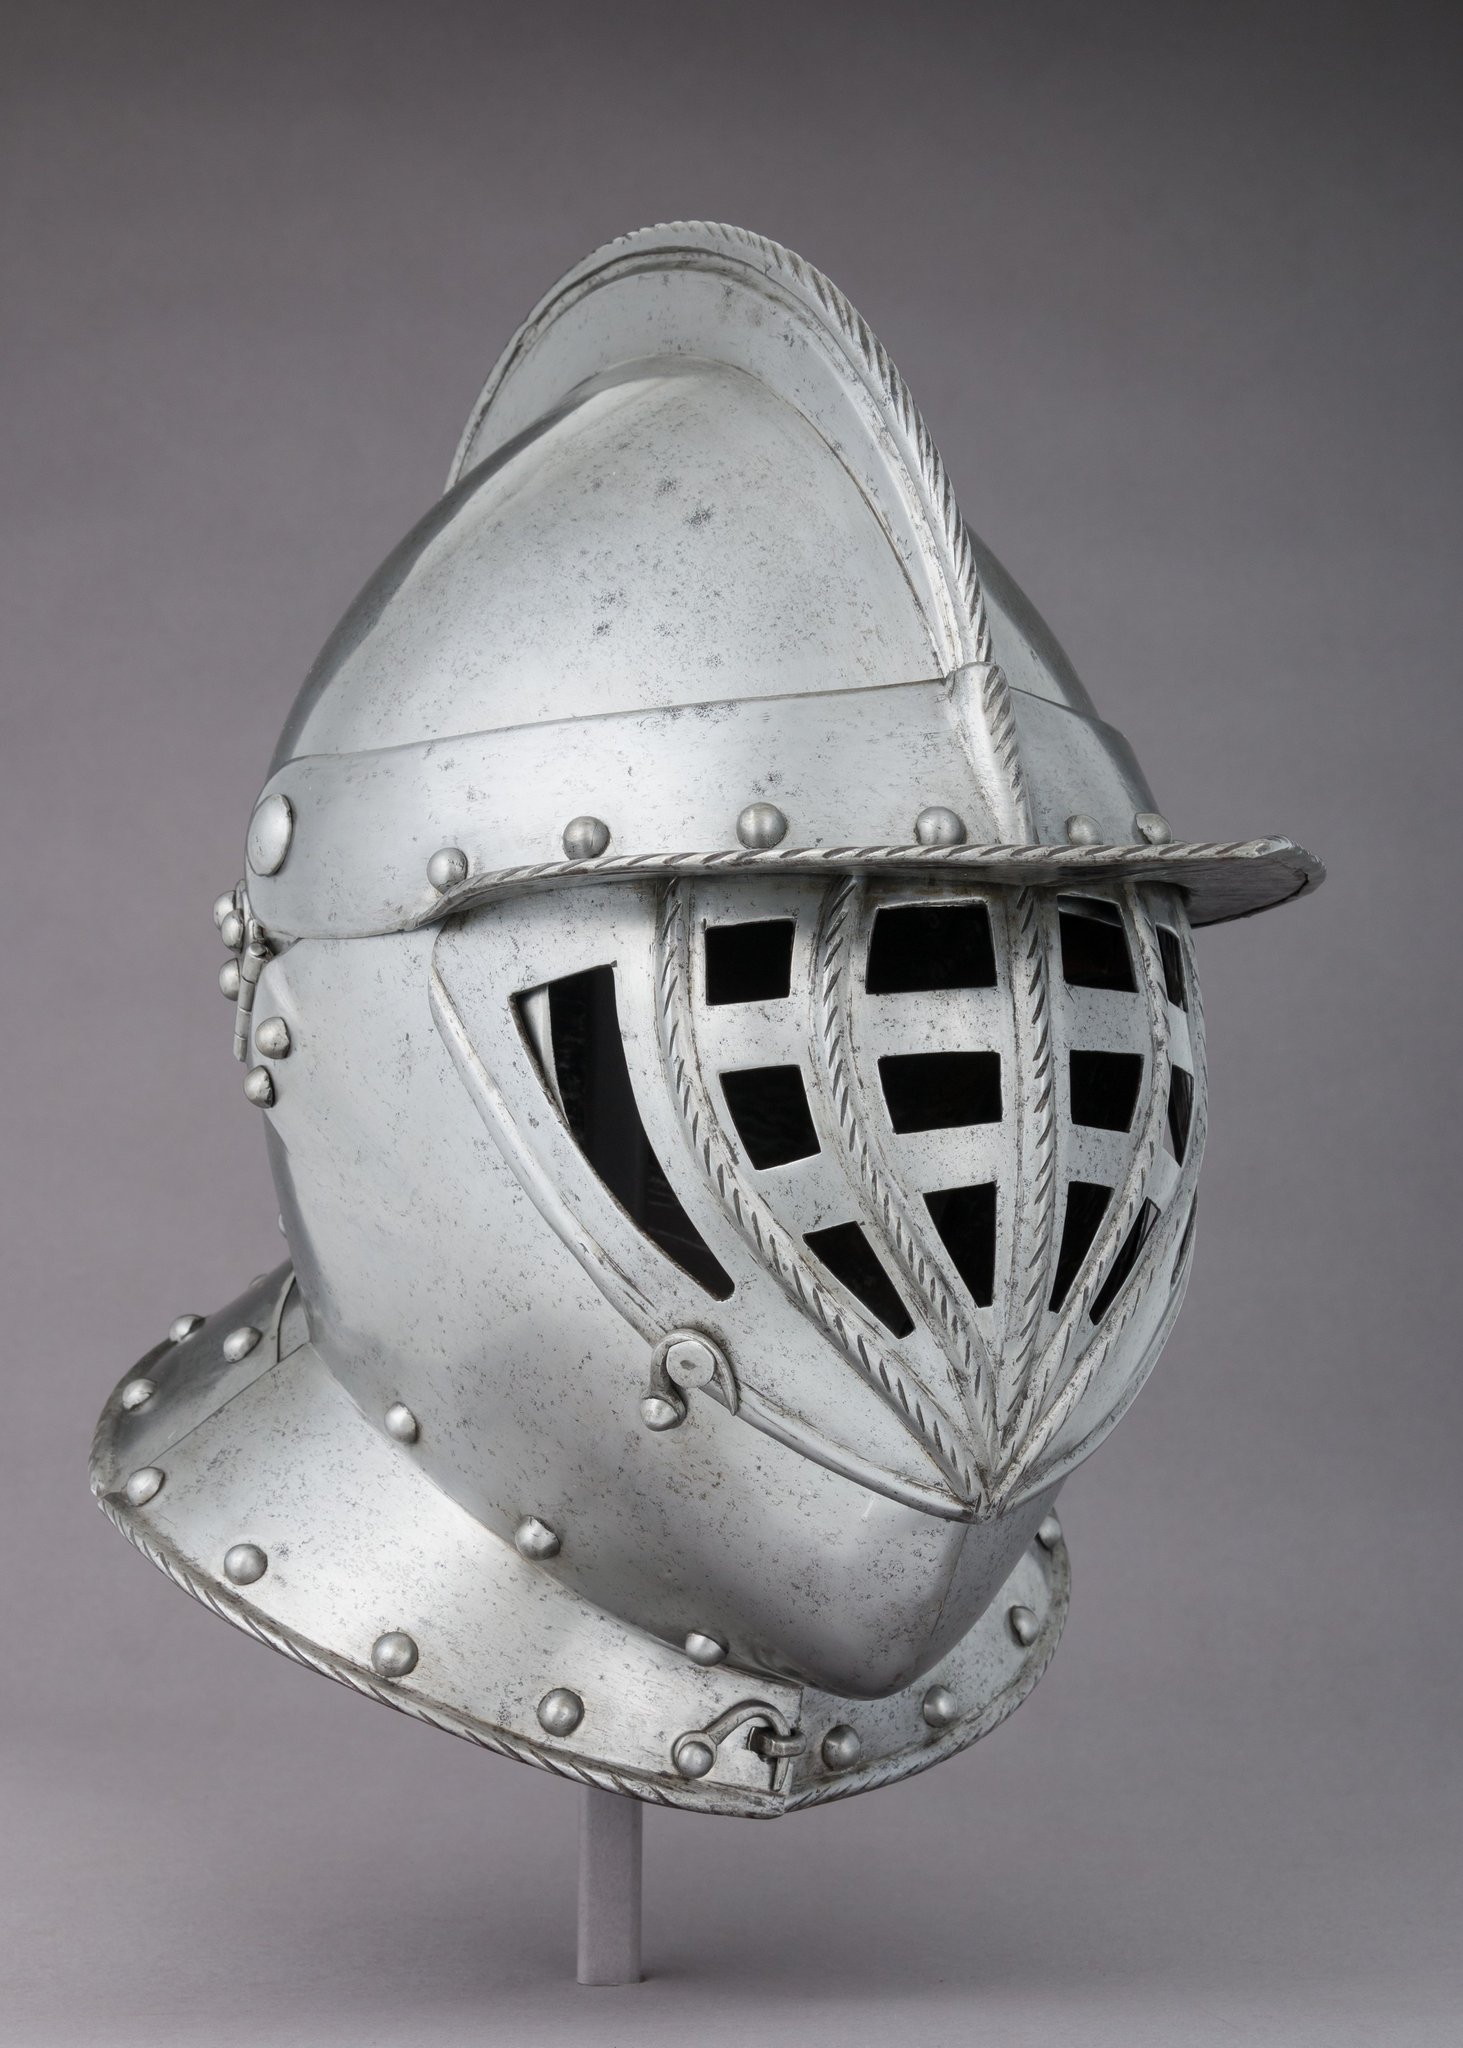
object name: closed burgonet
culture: german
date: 1610-1620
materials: leather, steel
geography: germany